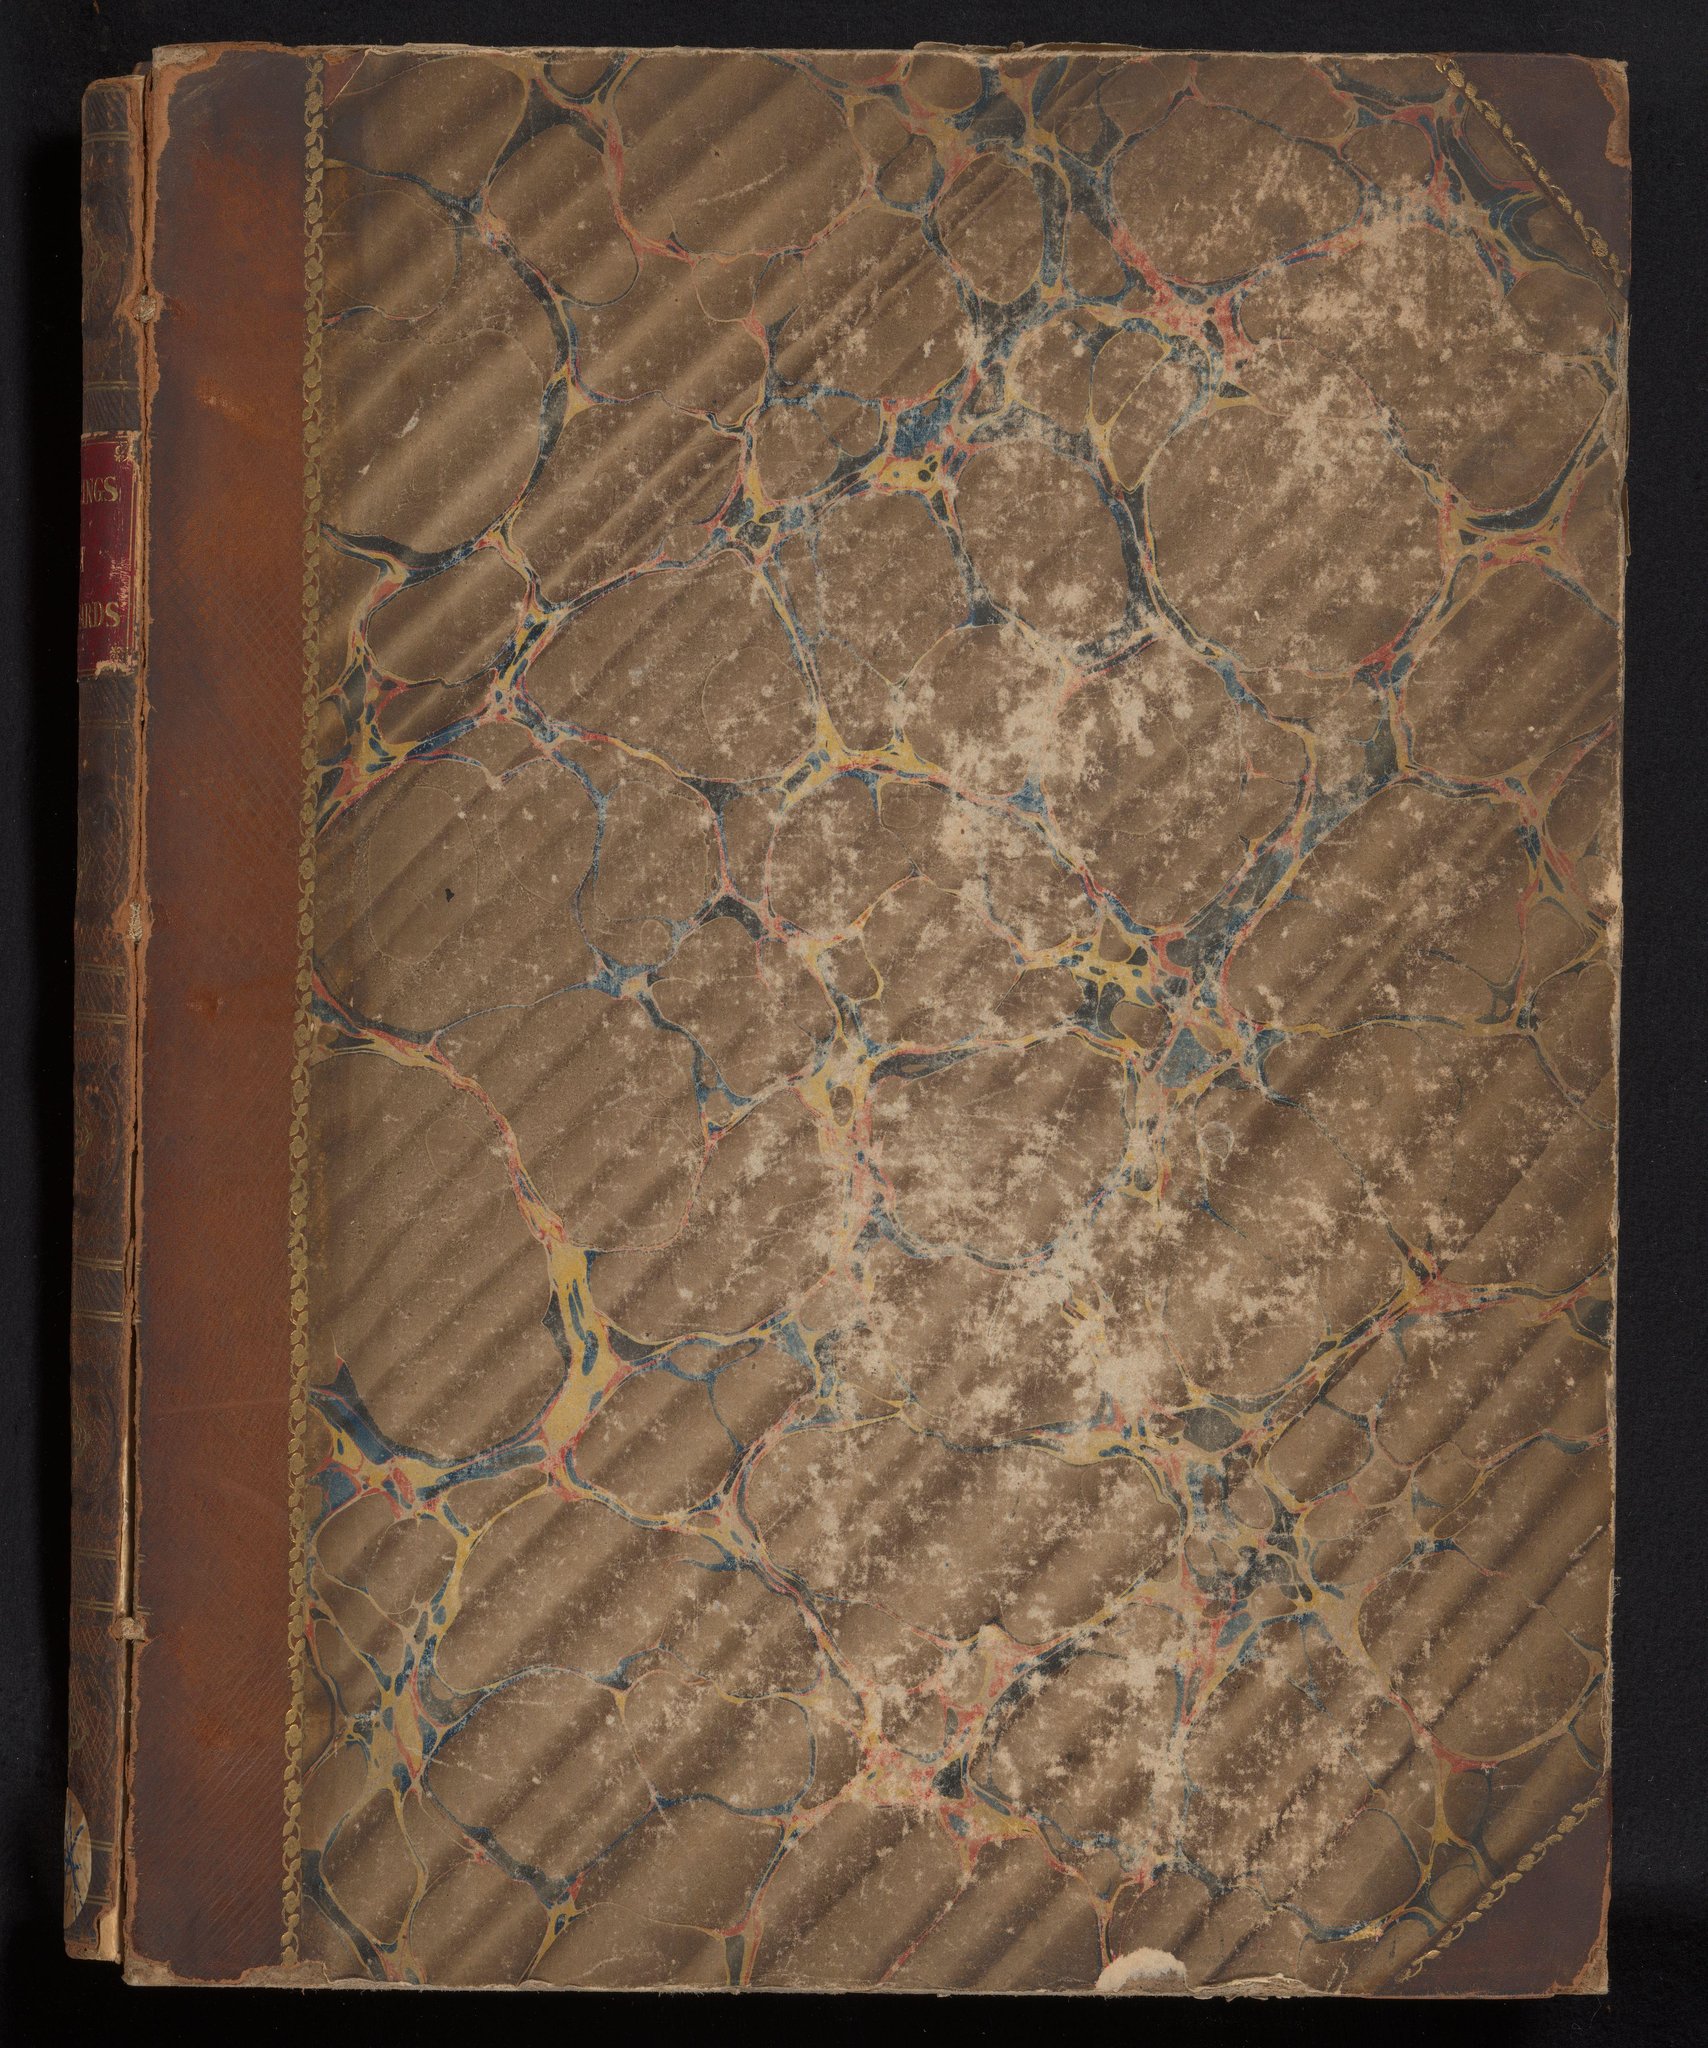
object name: prentrecueil, prentenalbum, prentalbum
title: Etchings by E. Edwards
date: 1748-1806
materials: cardboard, ink, leather, paper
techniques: printing, etching, writing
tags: landscapes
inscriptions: annotation: ‘99 B 14’, : ‘Edward Edwards/ This ingenious artist was born March 7th 1738 in Castle Street, Leicester Fields, where his father was a/ chair maker and carver. At the age of fifteen, his father who/ had intended him for his over business, discovering in/ him some (...) Pilkington Vol 1st Page 289.’, annotation: ‘49 etchings & a Portrait’, collector's mark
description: Factice album met 50 prenten op 50 albumbladen. Factice album, dat wil zeggen: een door een verzamelaar of eigenaar van de prenten samengesteld album. Introductie met een handgeschreven biografie van Edward Edwards zoals overgenomen uit Pilkington's 'A Dictionary of Painters' uit 1805. Het album bevat etsen van landschappen en portretten.